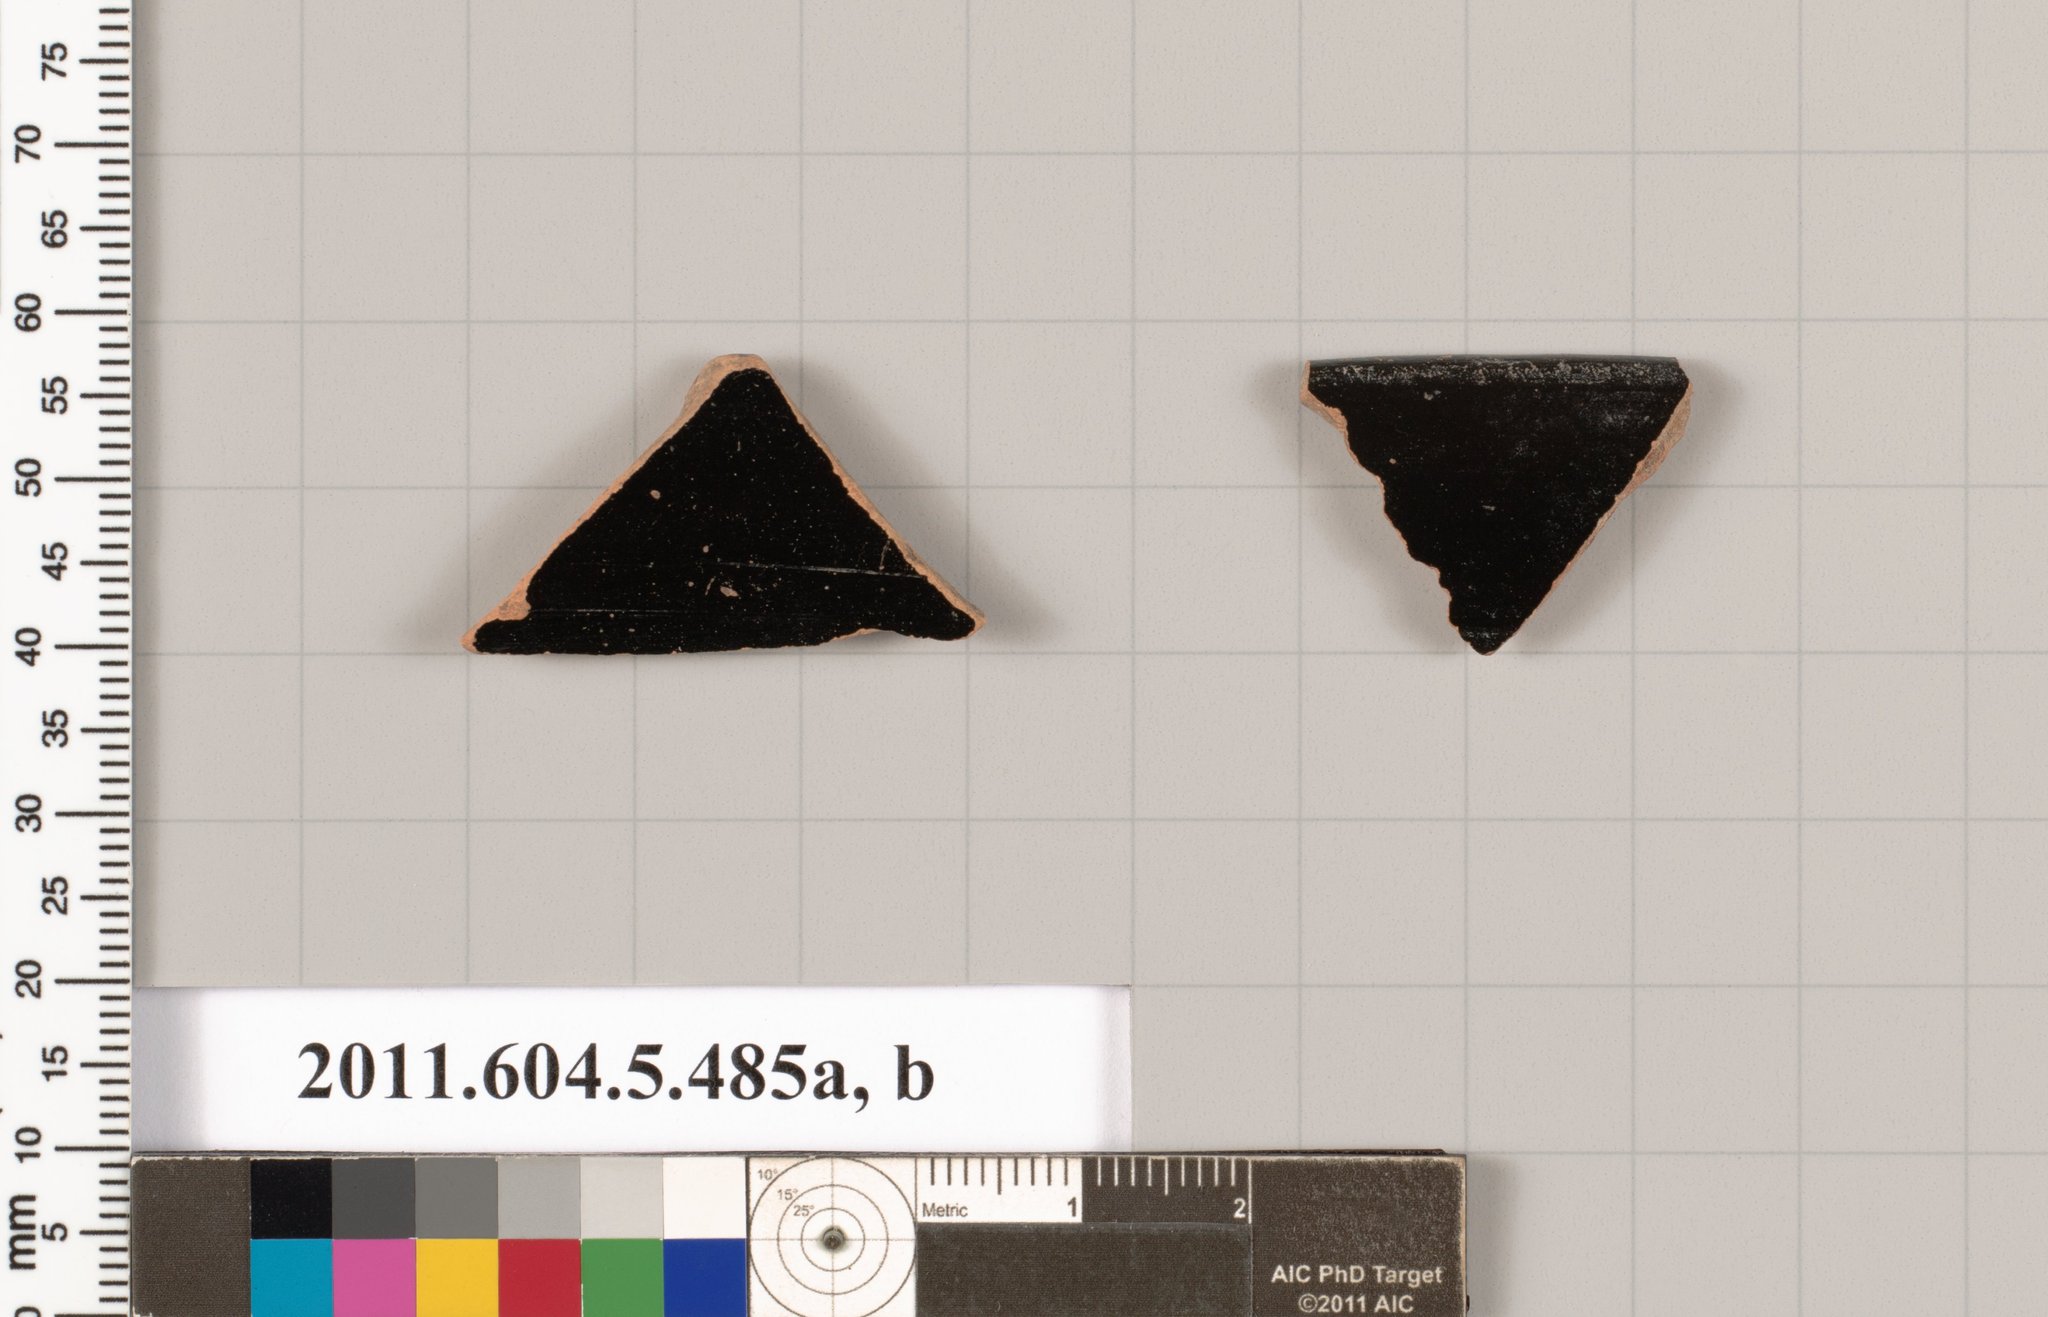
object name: kylix fragment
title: Terracotta rim fragments of kylikes (drinking cups)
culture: greek, attic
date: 600-401 BCE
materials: terracotta